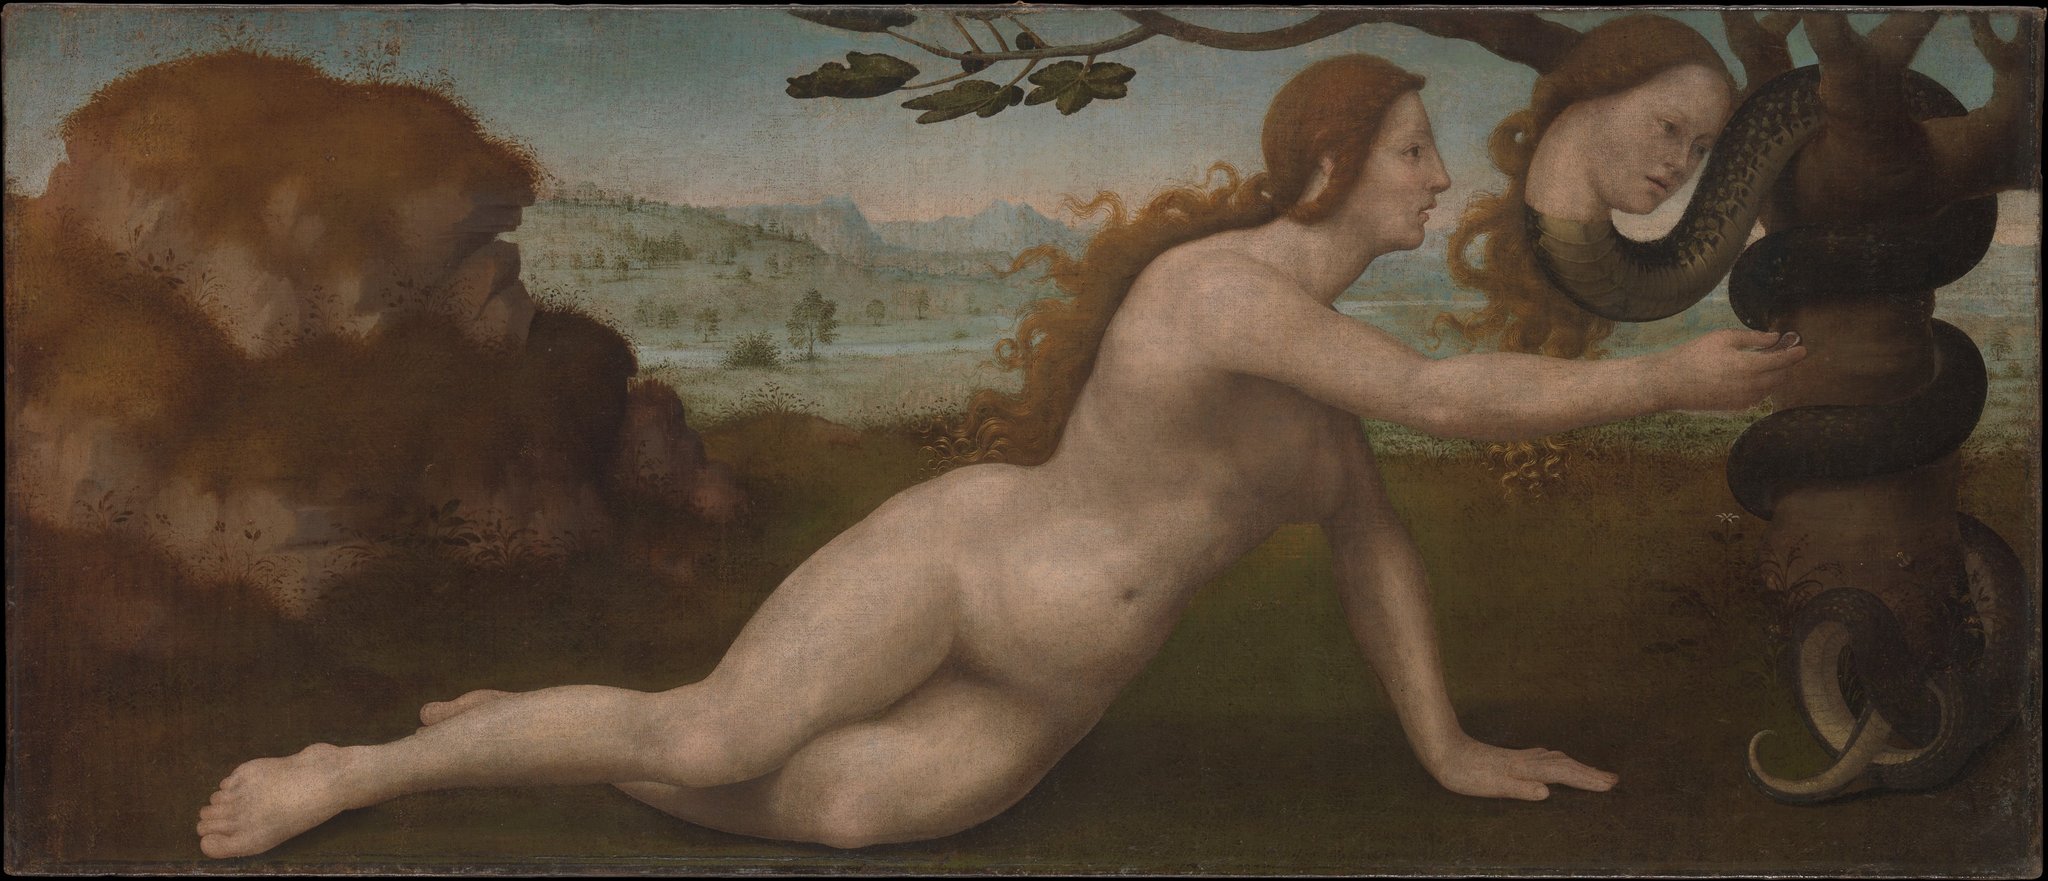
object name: painting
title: Adam; Eve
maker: giuliano di piero di simone bugiardini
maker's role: artist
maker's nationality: italian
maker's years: 1475-1554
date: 1520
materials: canvas, oil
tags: snakes,adam,eve